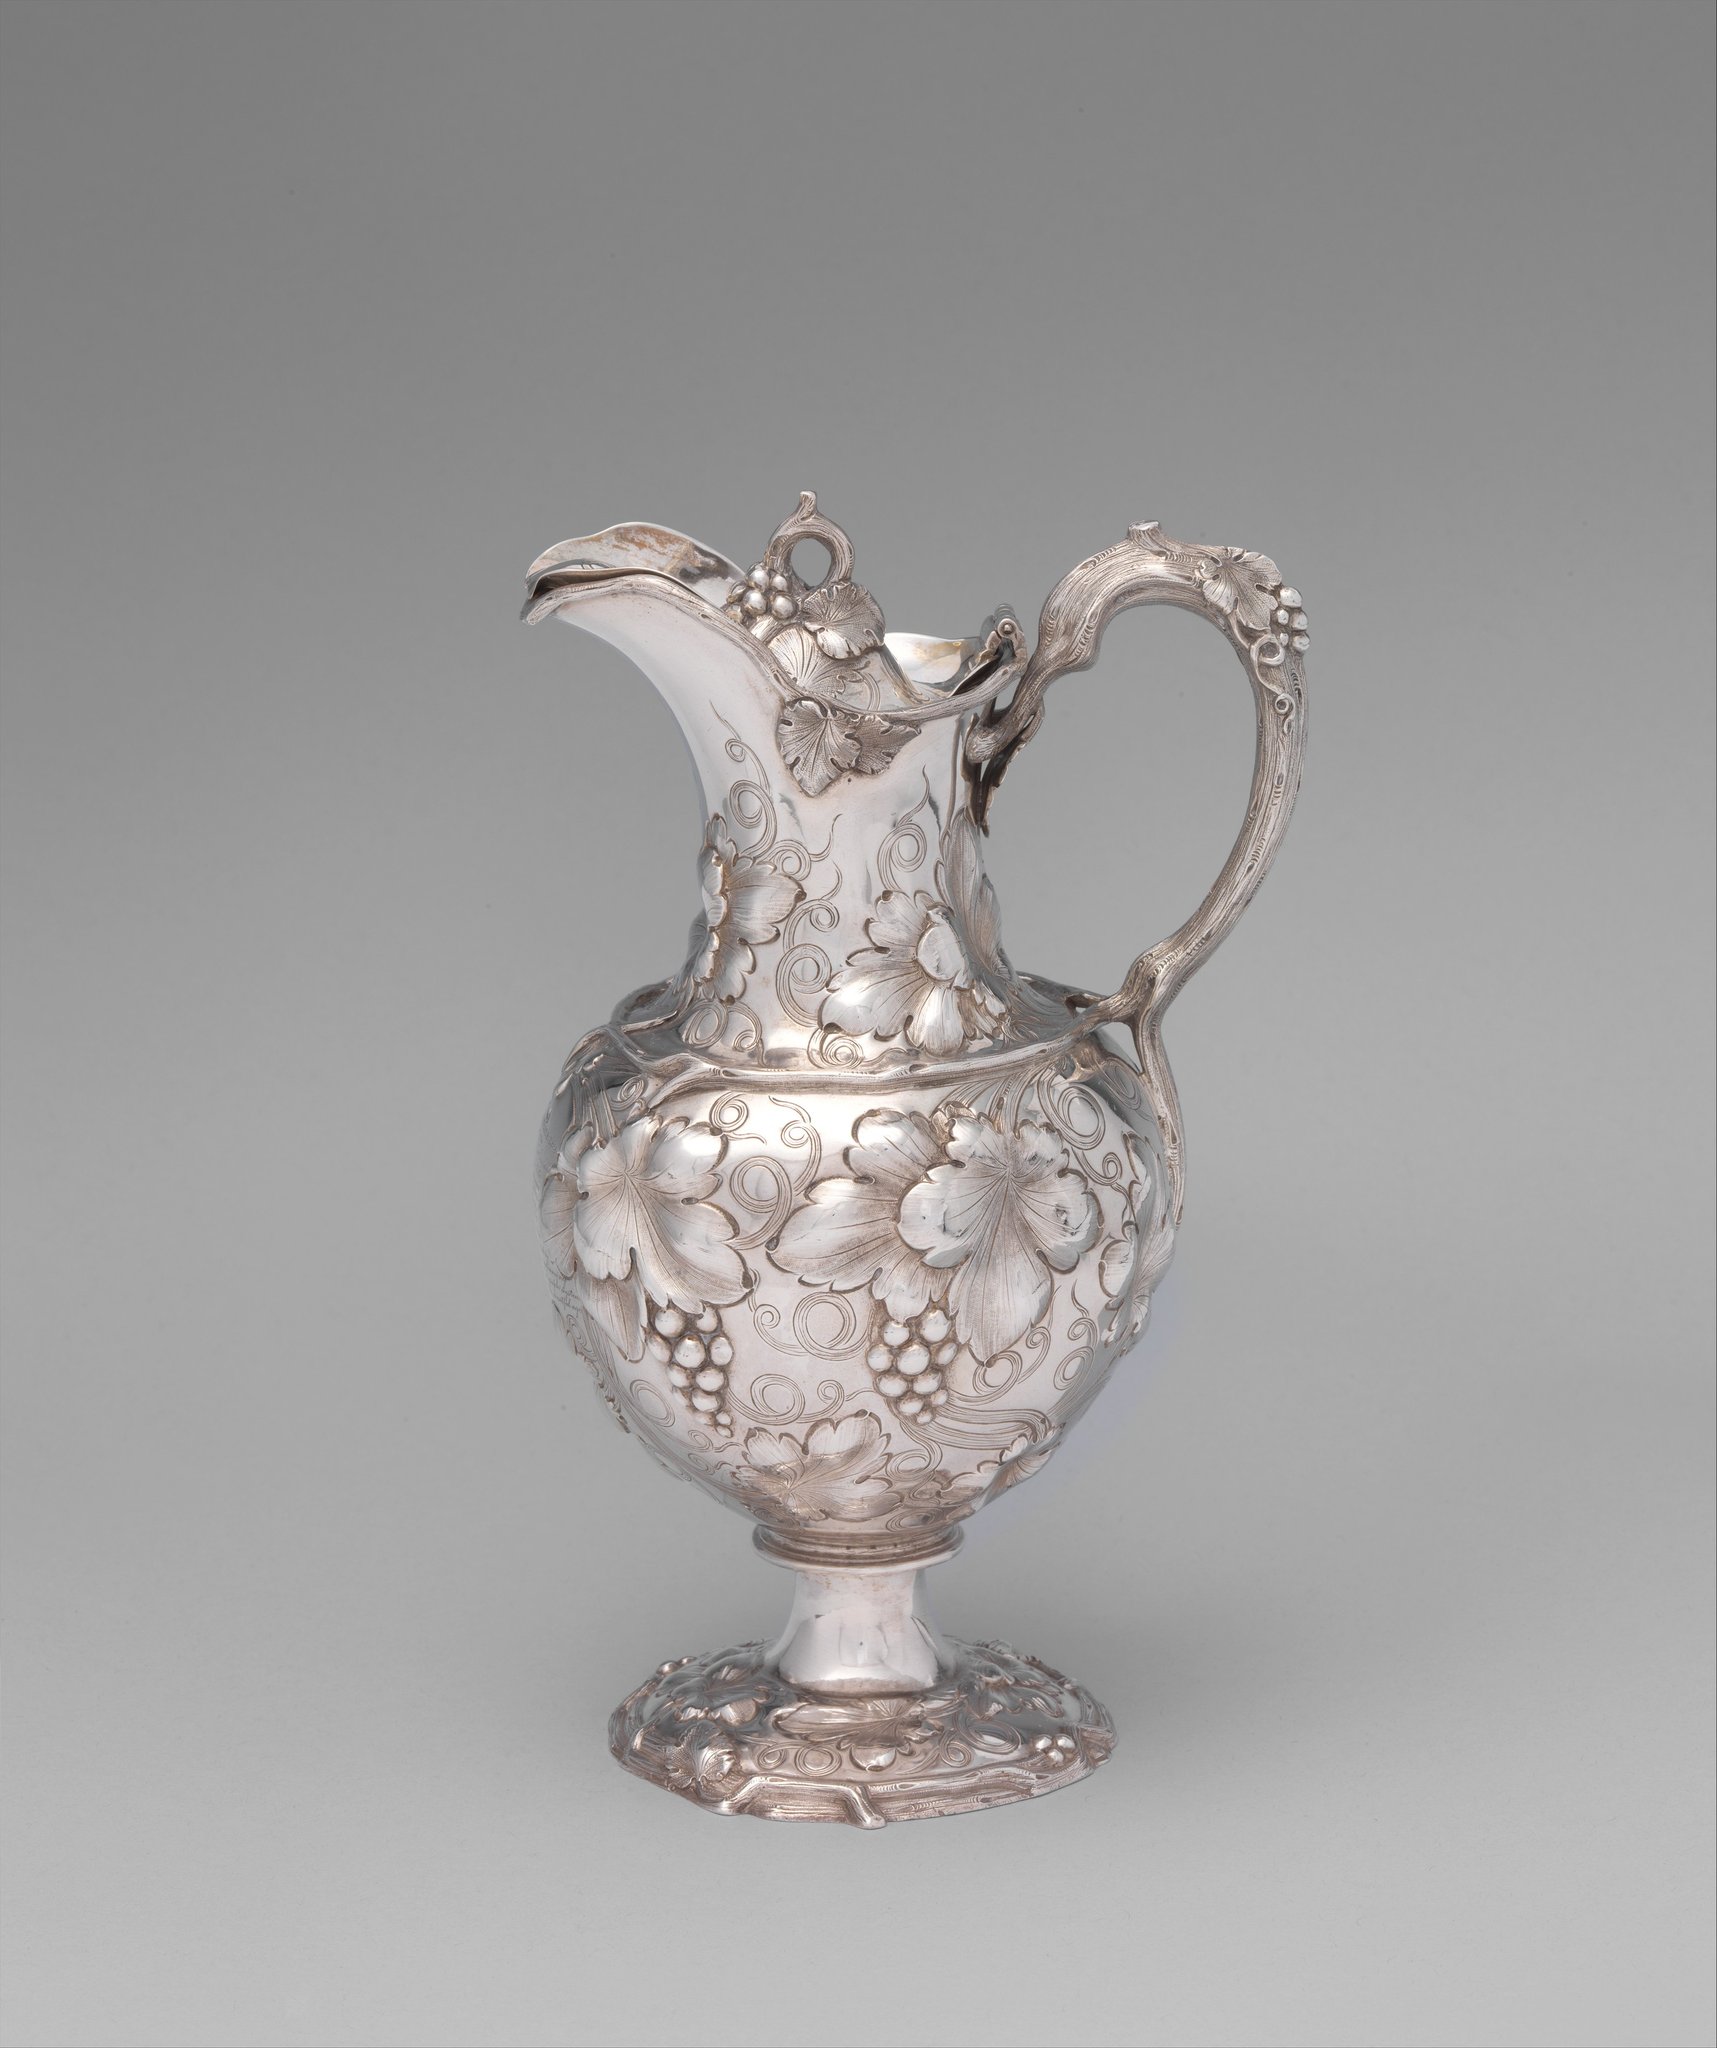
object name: cream pot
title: Milk Pot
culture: american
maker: john c. moore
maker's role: maker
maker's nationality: american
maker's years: 1799-1874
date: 1850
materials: silver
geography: united states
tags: grapes,flowers